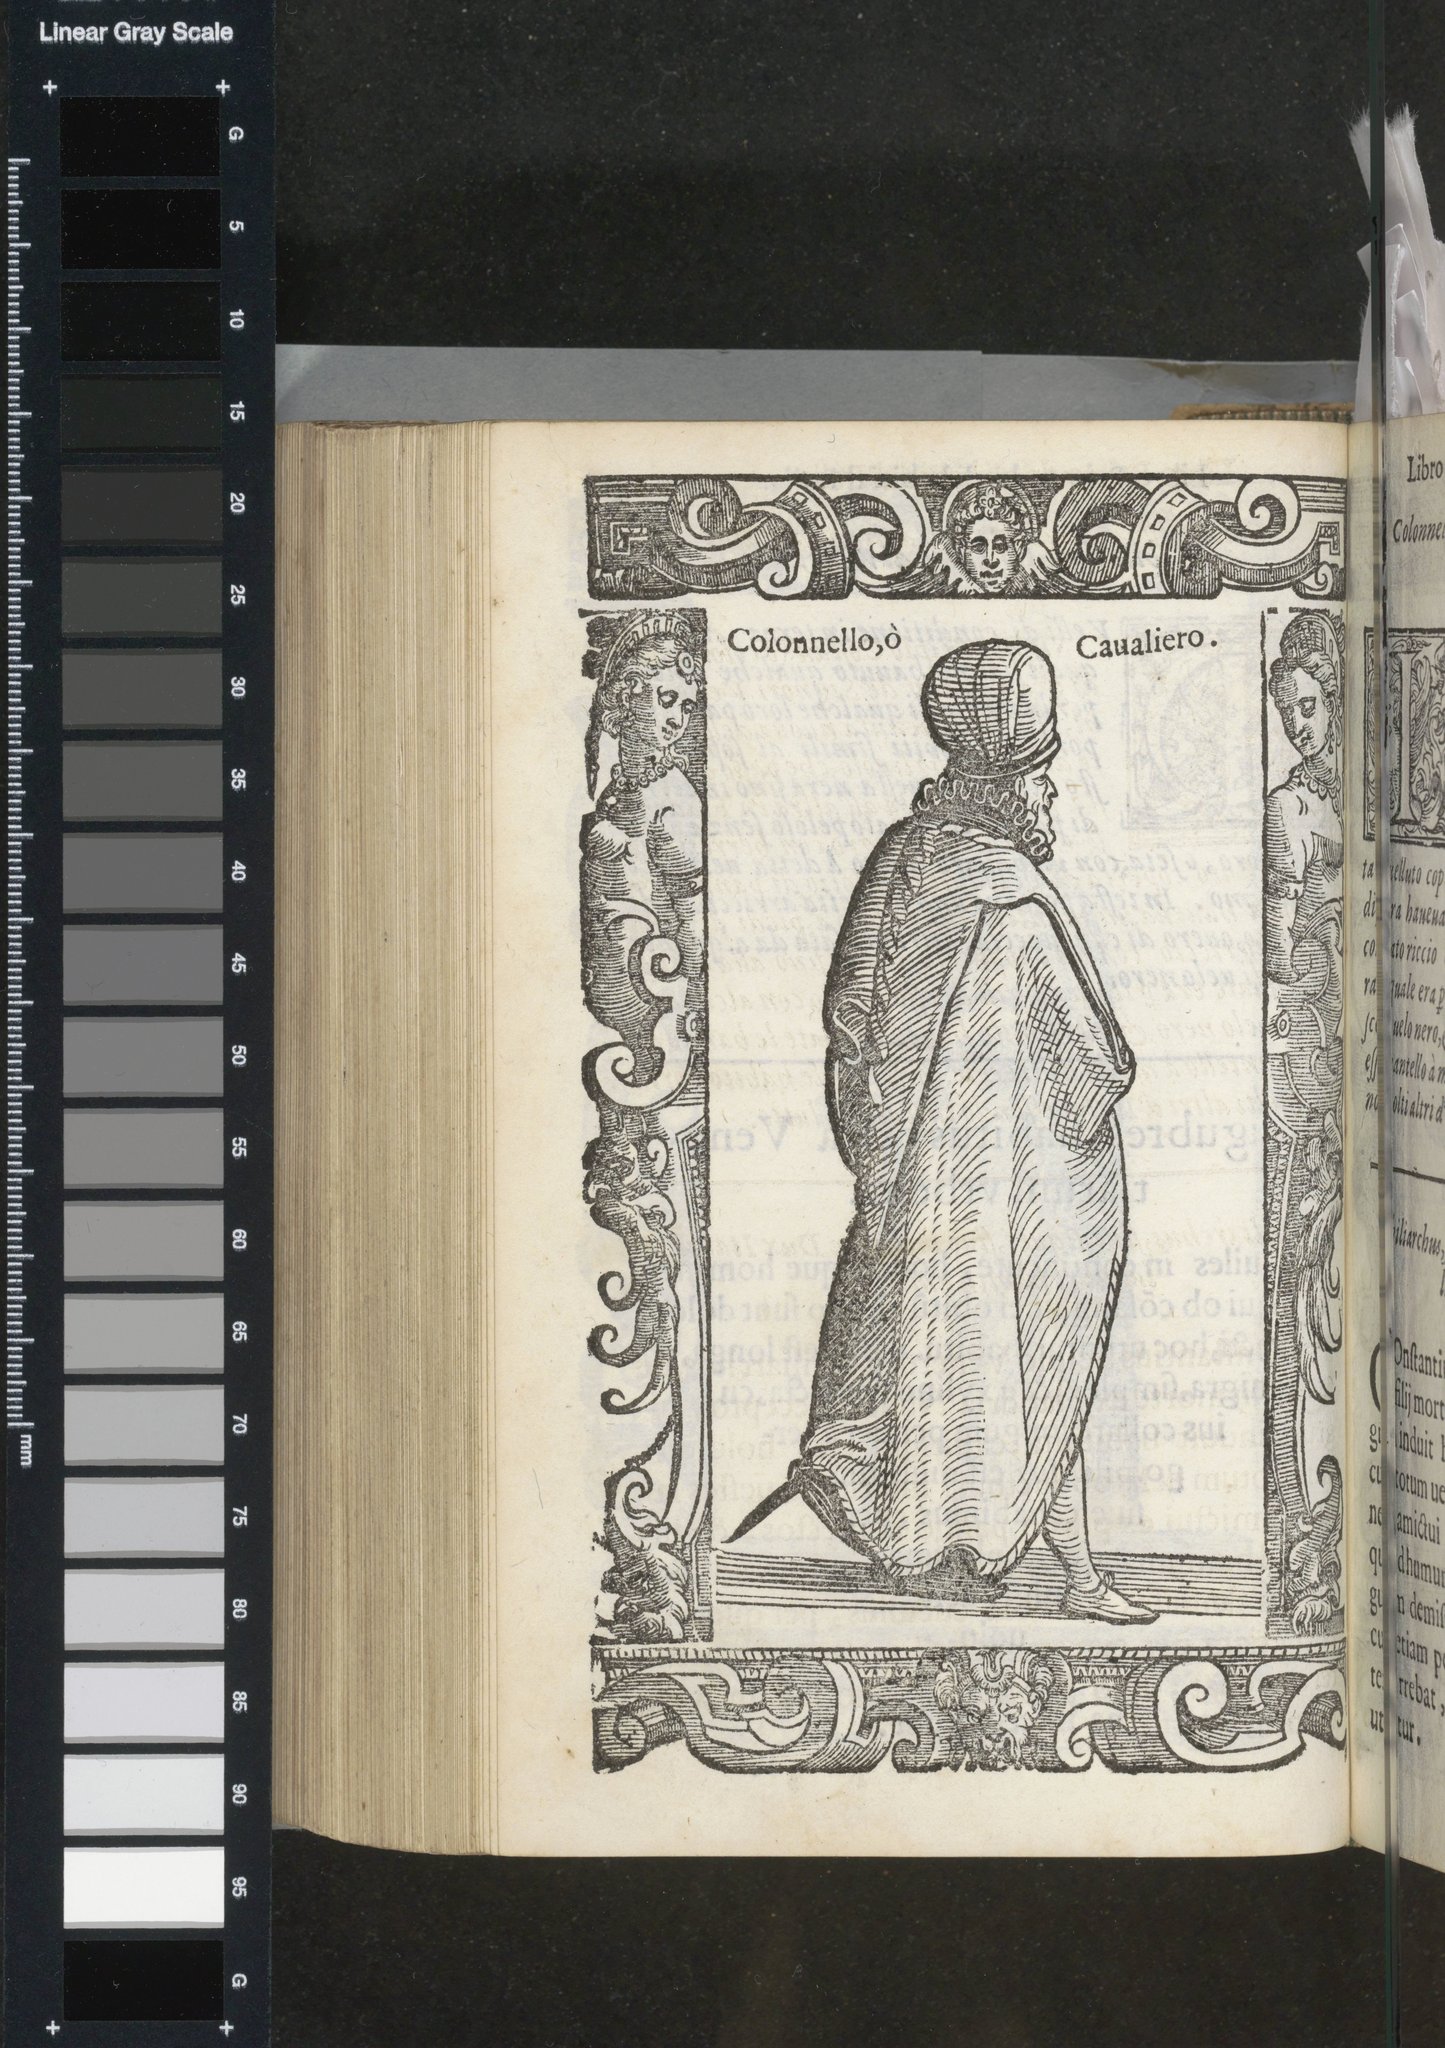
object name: costume print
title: Habiti antichi, et moderni di tutto il mondo...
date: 1598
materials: paper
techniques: woodcut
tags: fashion plates